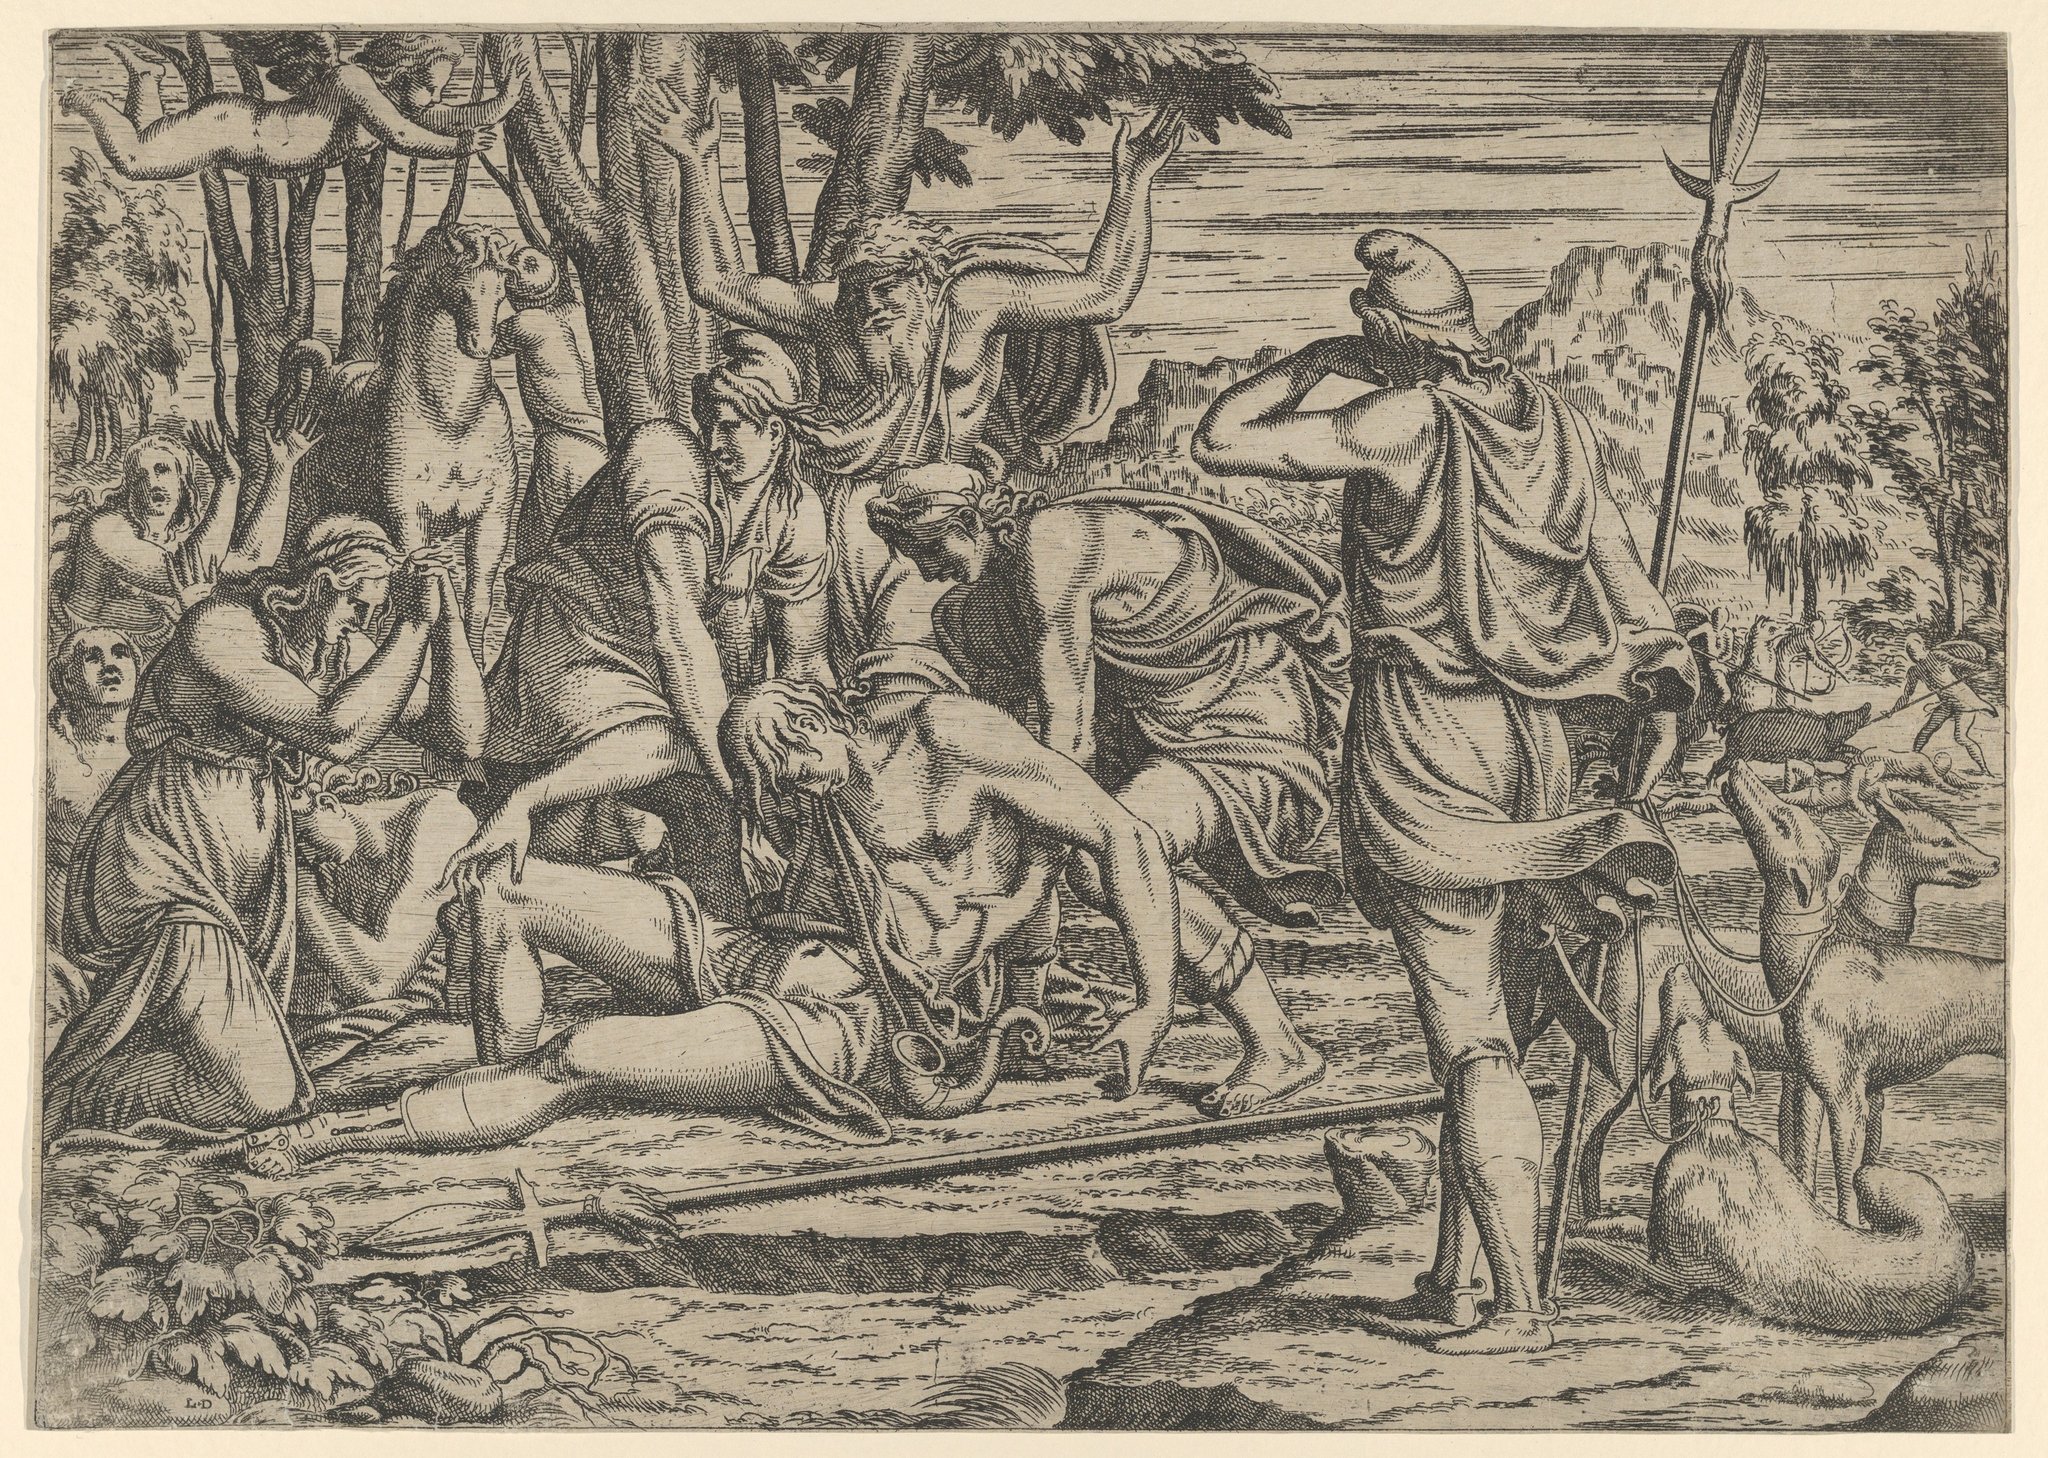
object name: print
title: Death of Adonis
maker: léon davent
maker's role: artist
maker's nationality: french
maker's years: 1540-1556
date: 1540-1556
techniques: etching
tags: animals,spears,adonis,death